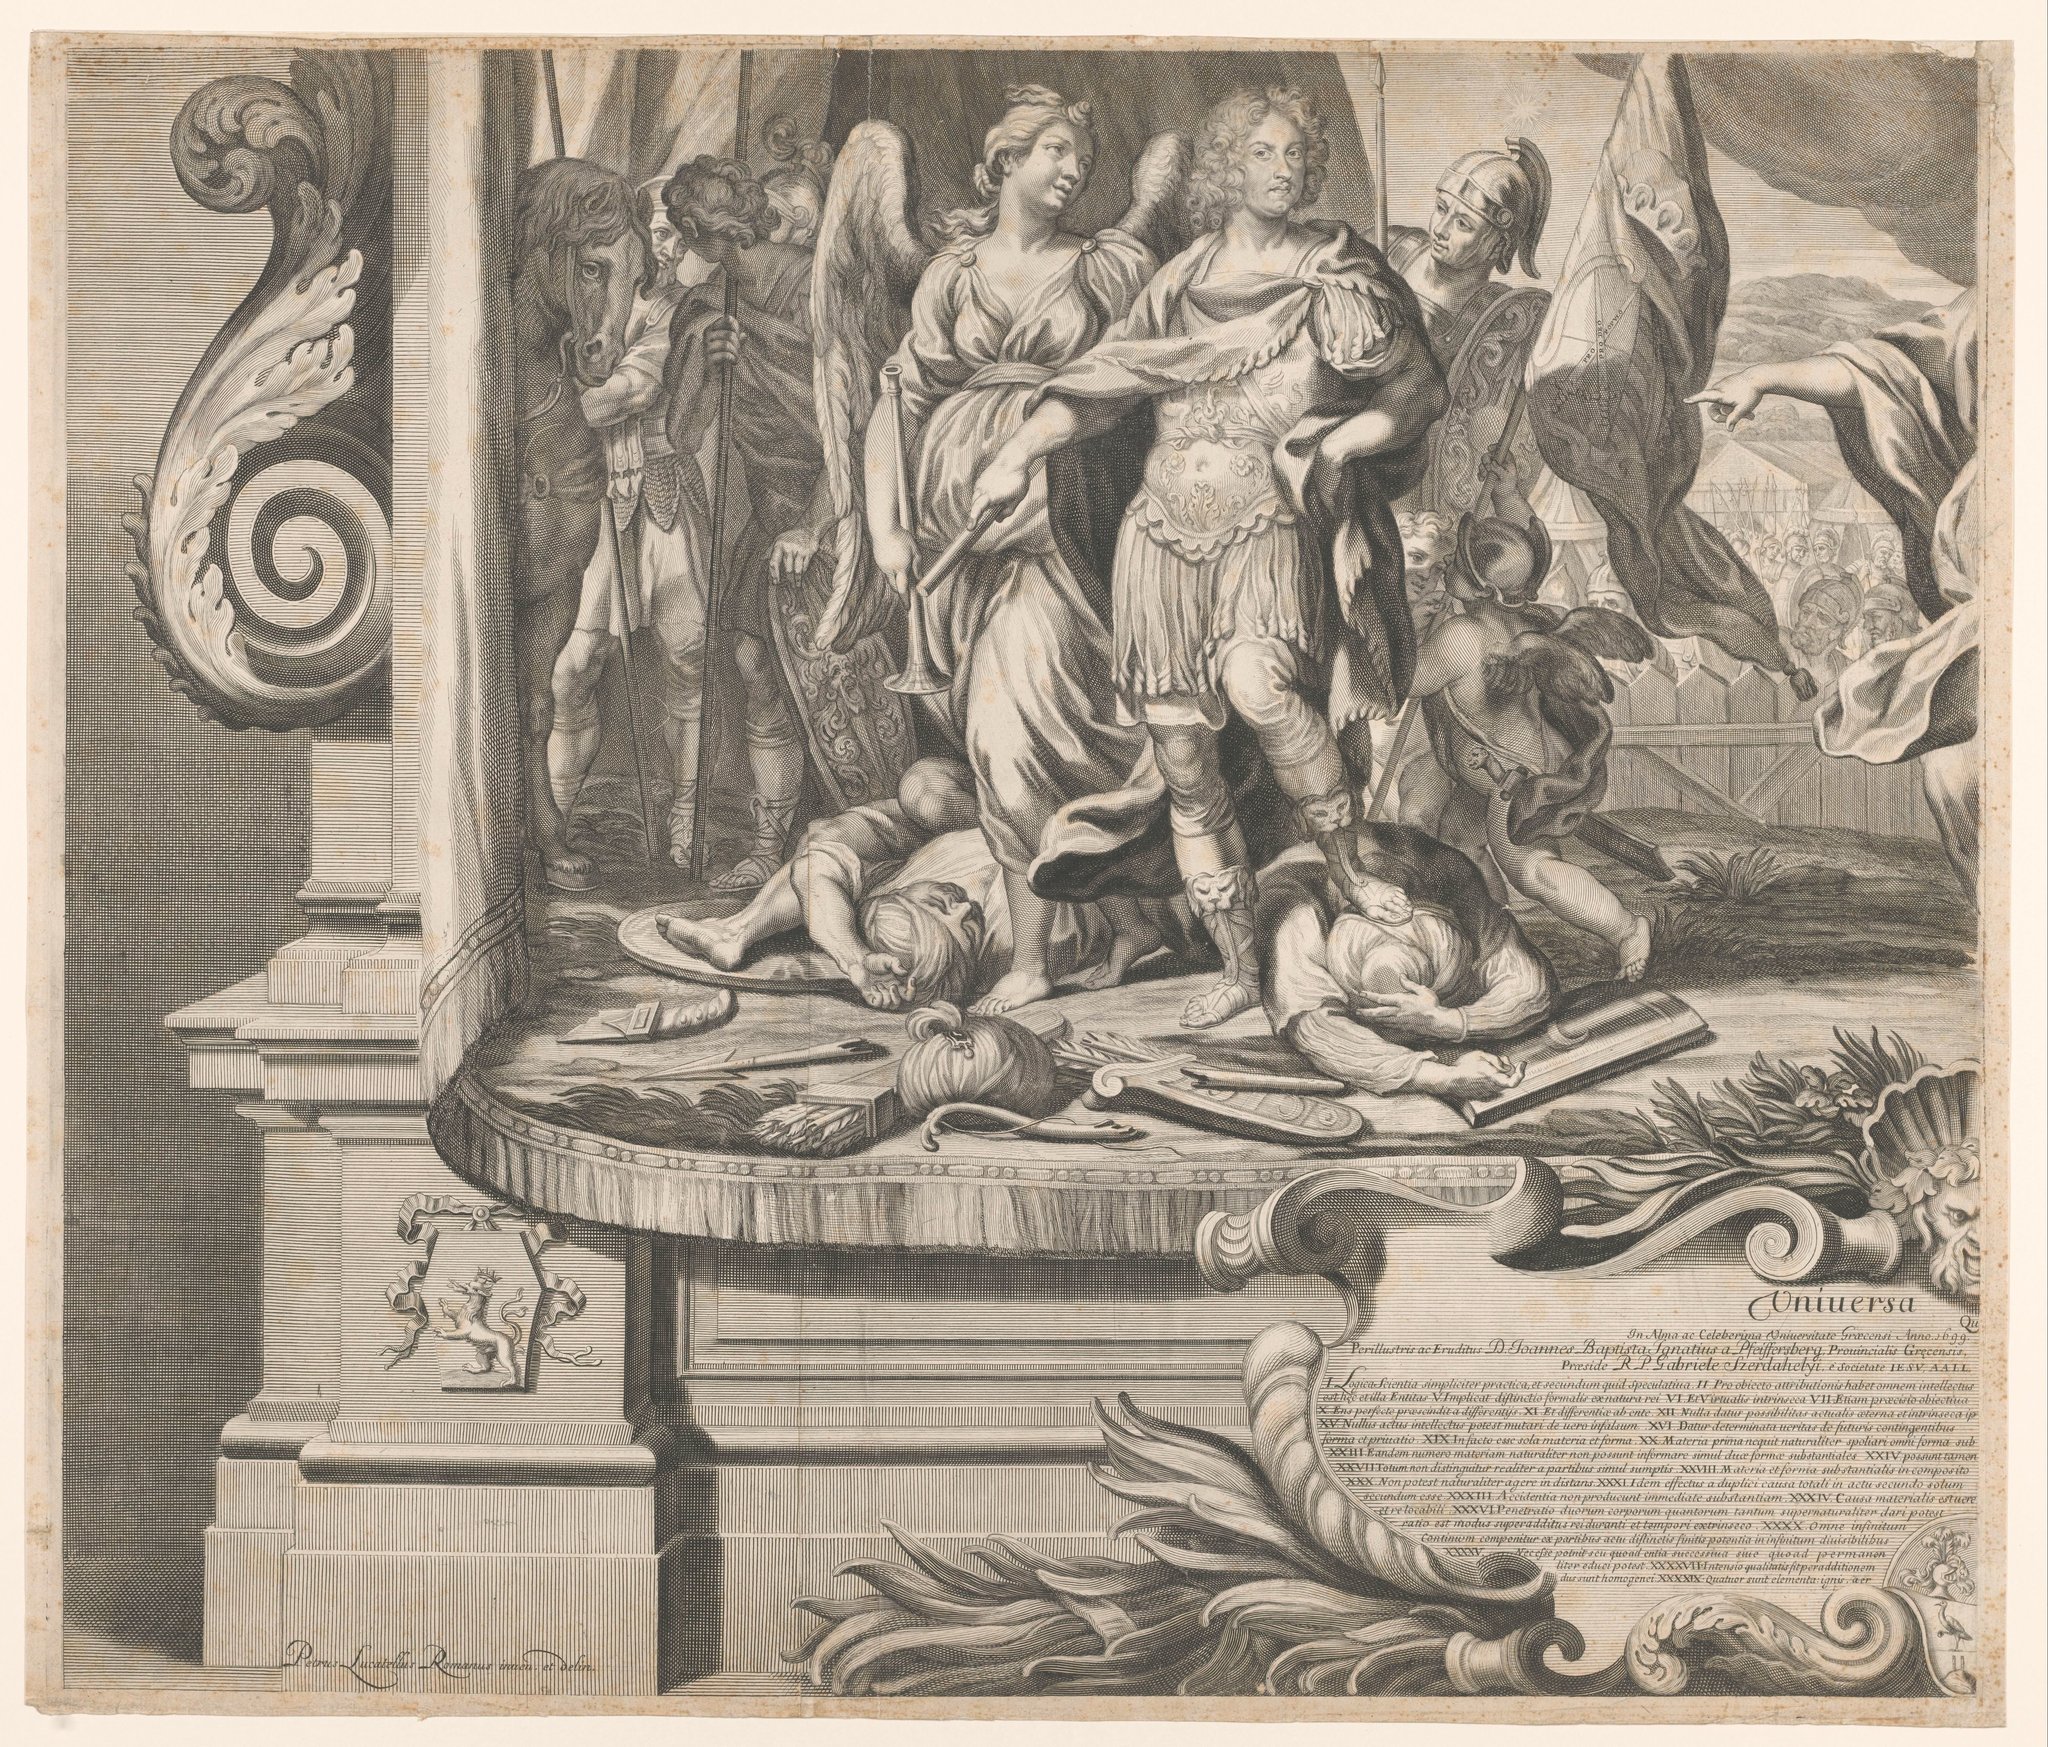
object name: print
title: Promotieprent voor Joannes Baptista a Pfeiffersberg (blad voor linksonder)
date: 1699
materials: paper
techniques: engraving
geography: rome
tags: august ii (king of poland), king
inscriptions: collector's mark: Lugt 240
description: August II van Polen met links een engel en rechtsachter een deel van een leger. In de ondermarge een achttienregelig vers in het Latijn ter gelegenheid van de promotie van Joannes Baptista a Pfeiffersberg.